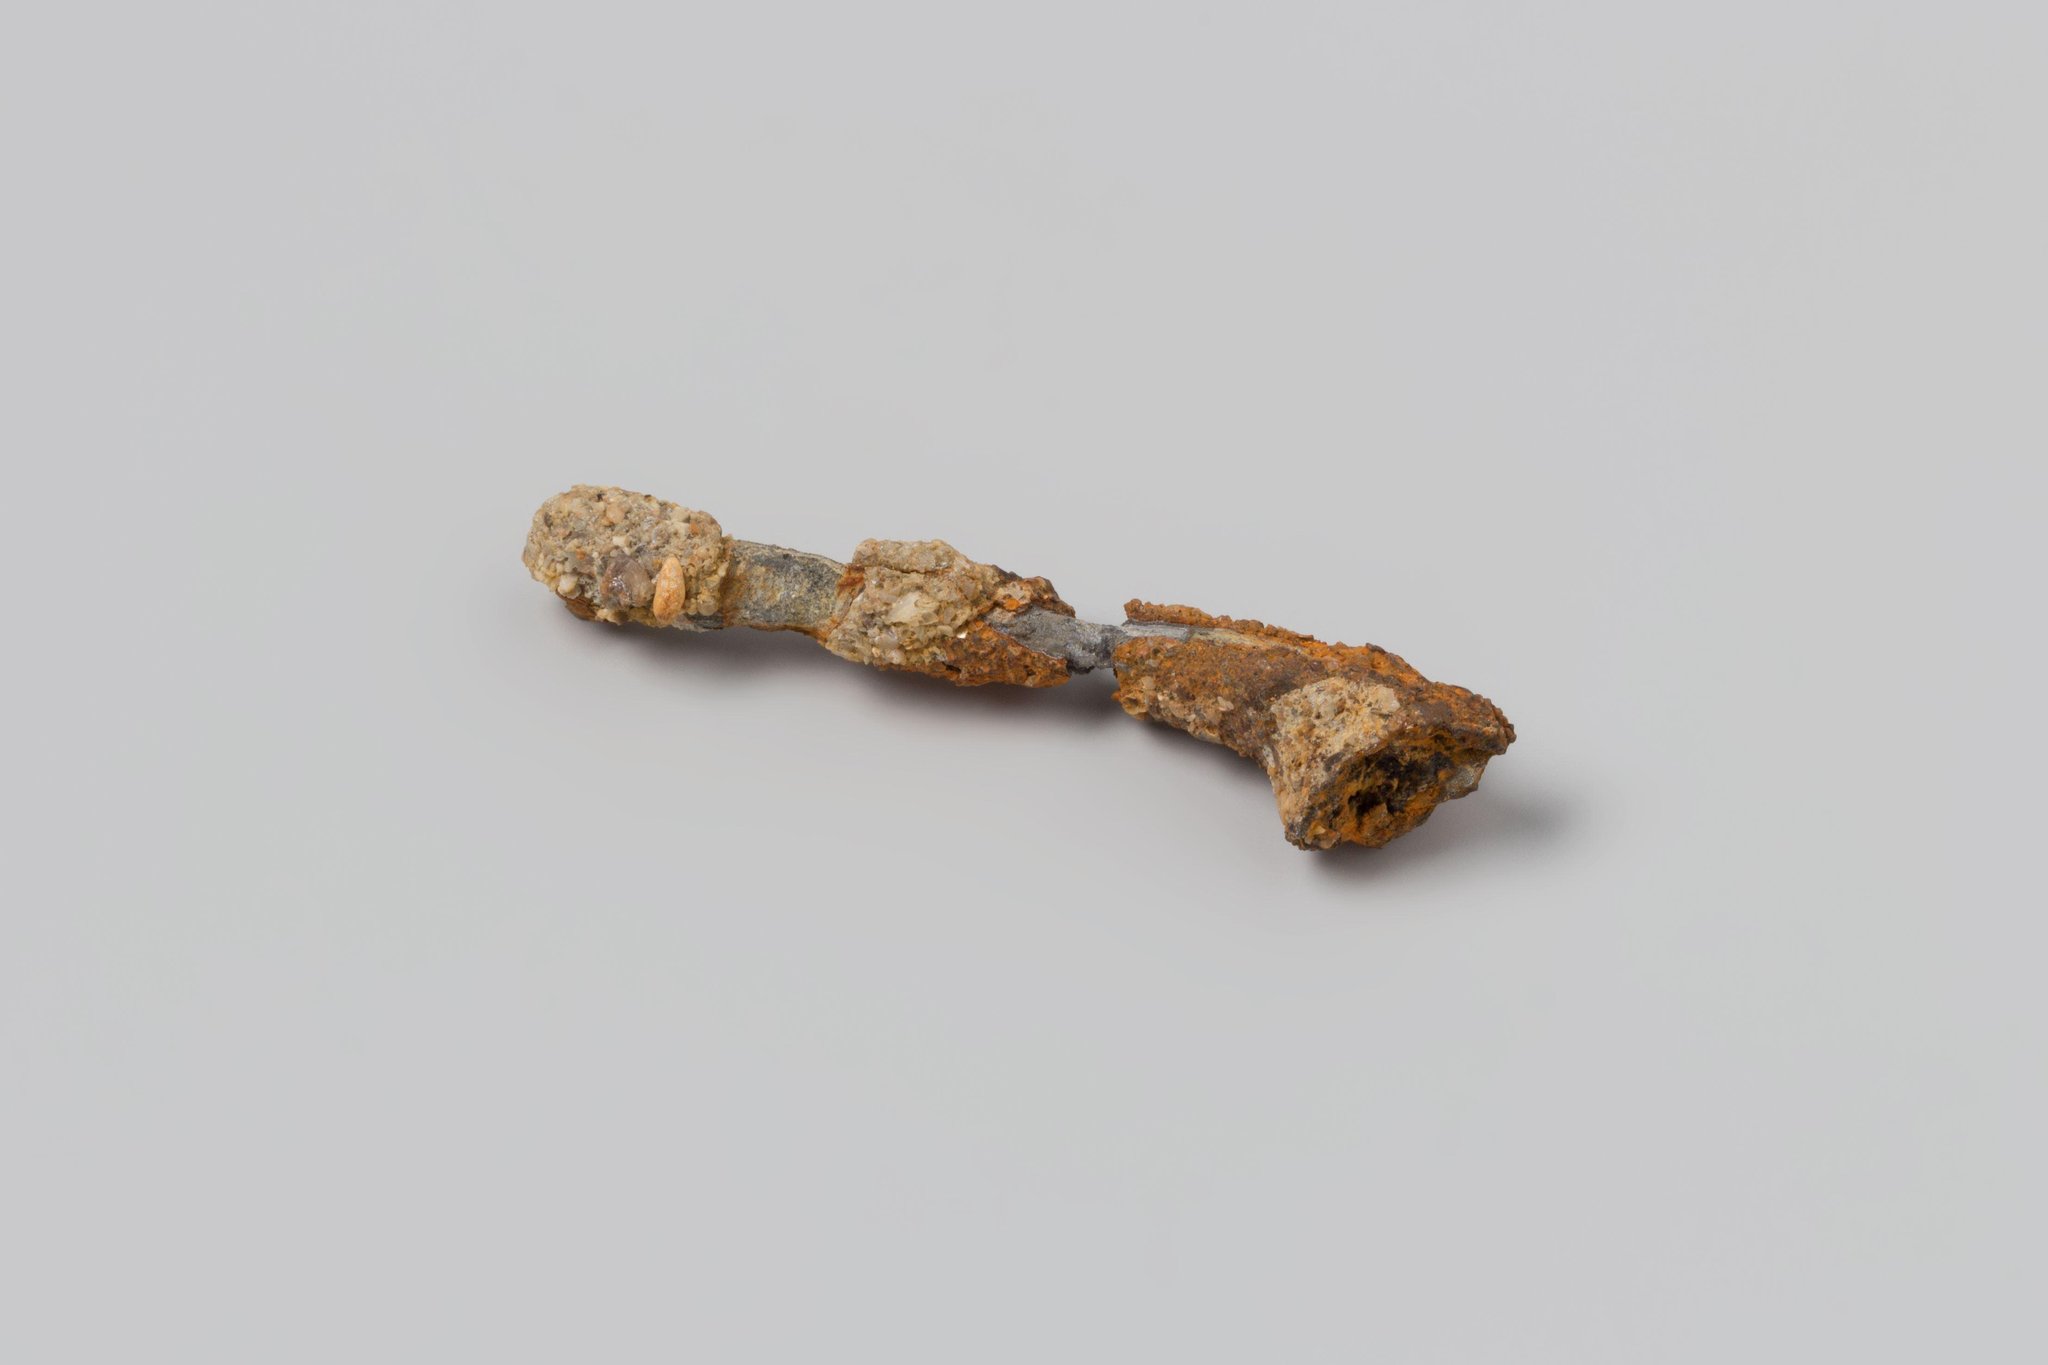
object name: spoon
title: Fragment steel van vork of lepel uit het wrak van de Oost-Indiëvaarder Hollandia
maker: Anonymous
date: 1700-1743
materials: tin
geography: netherlands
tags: verenigde oostindische compagnie, hollandia (schip), annet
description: Cutlery, fragment: stem of fork or spoon; fragm, heavily corroded.